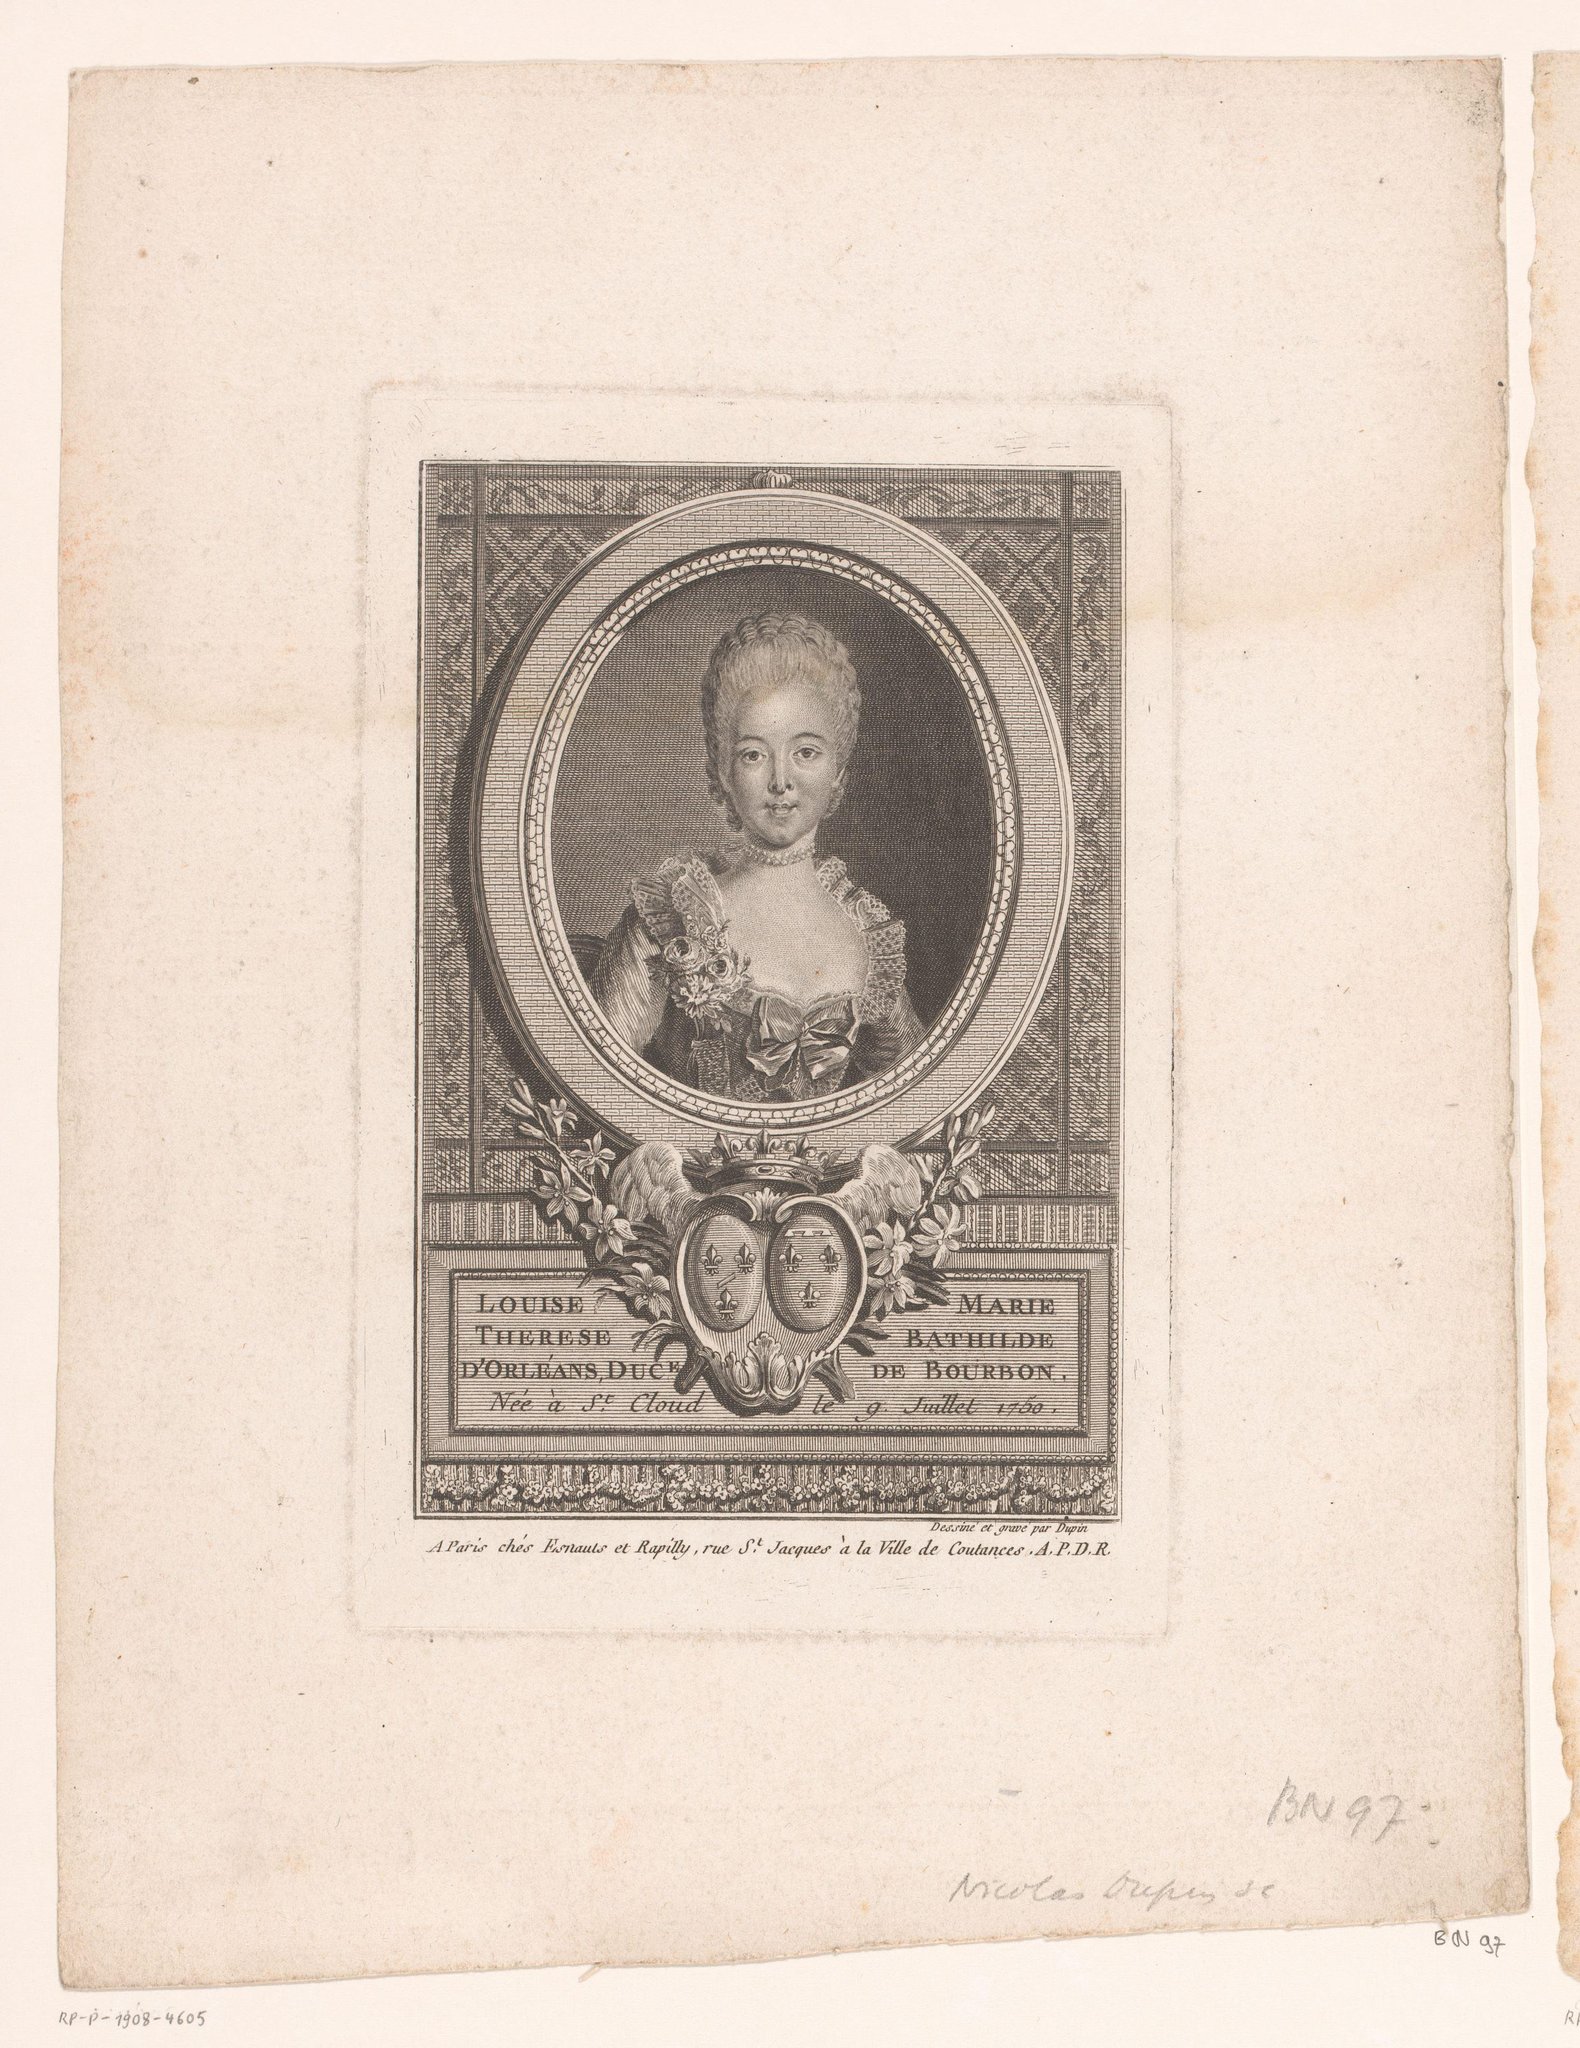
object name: print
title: Portret van Bathilde d'Orléans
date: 1776-1787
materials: paper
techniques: engraving, etching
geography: paris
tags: paris, historical persons - bb - woman, ornament ~ medallion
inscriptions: collector's mark: Lugt 2228